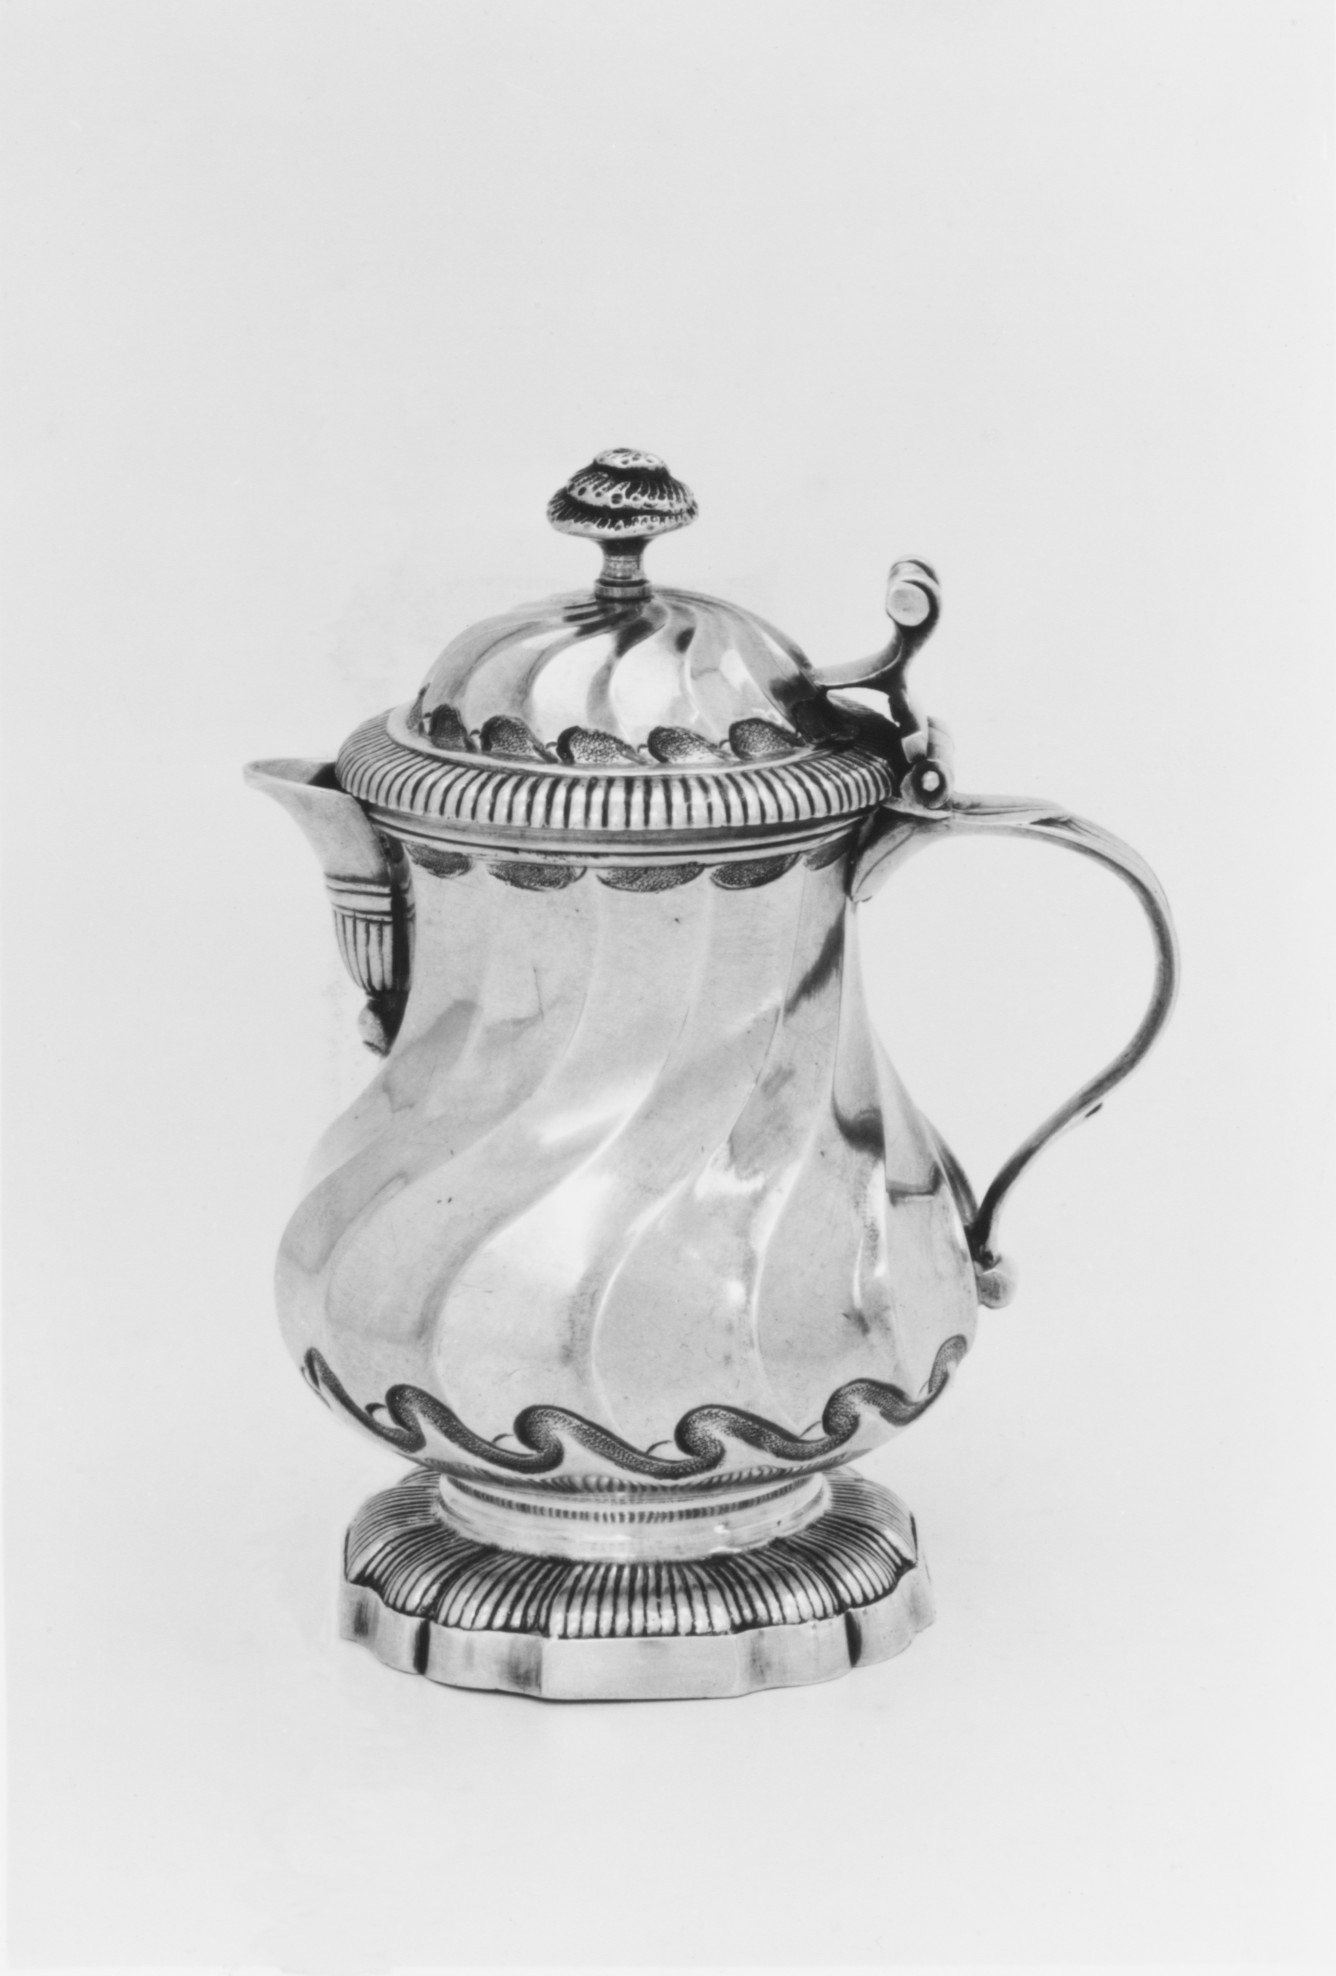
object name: mustard pot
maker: guillaume egée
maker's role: maker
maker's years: 1659-1759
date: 1748-1749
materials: silver